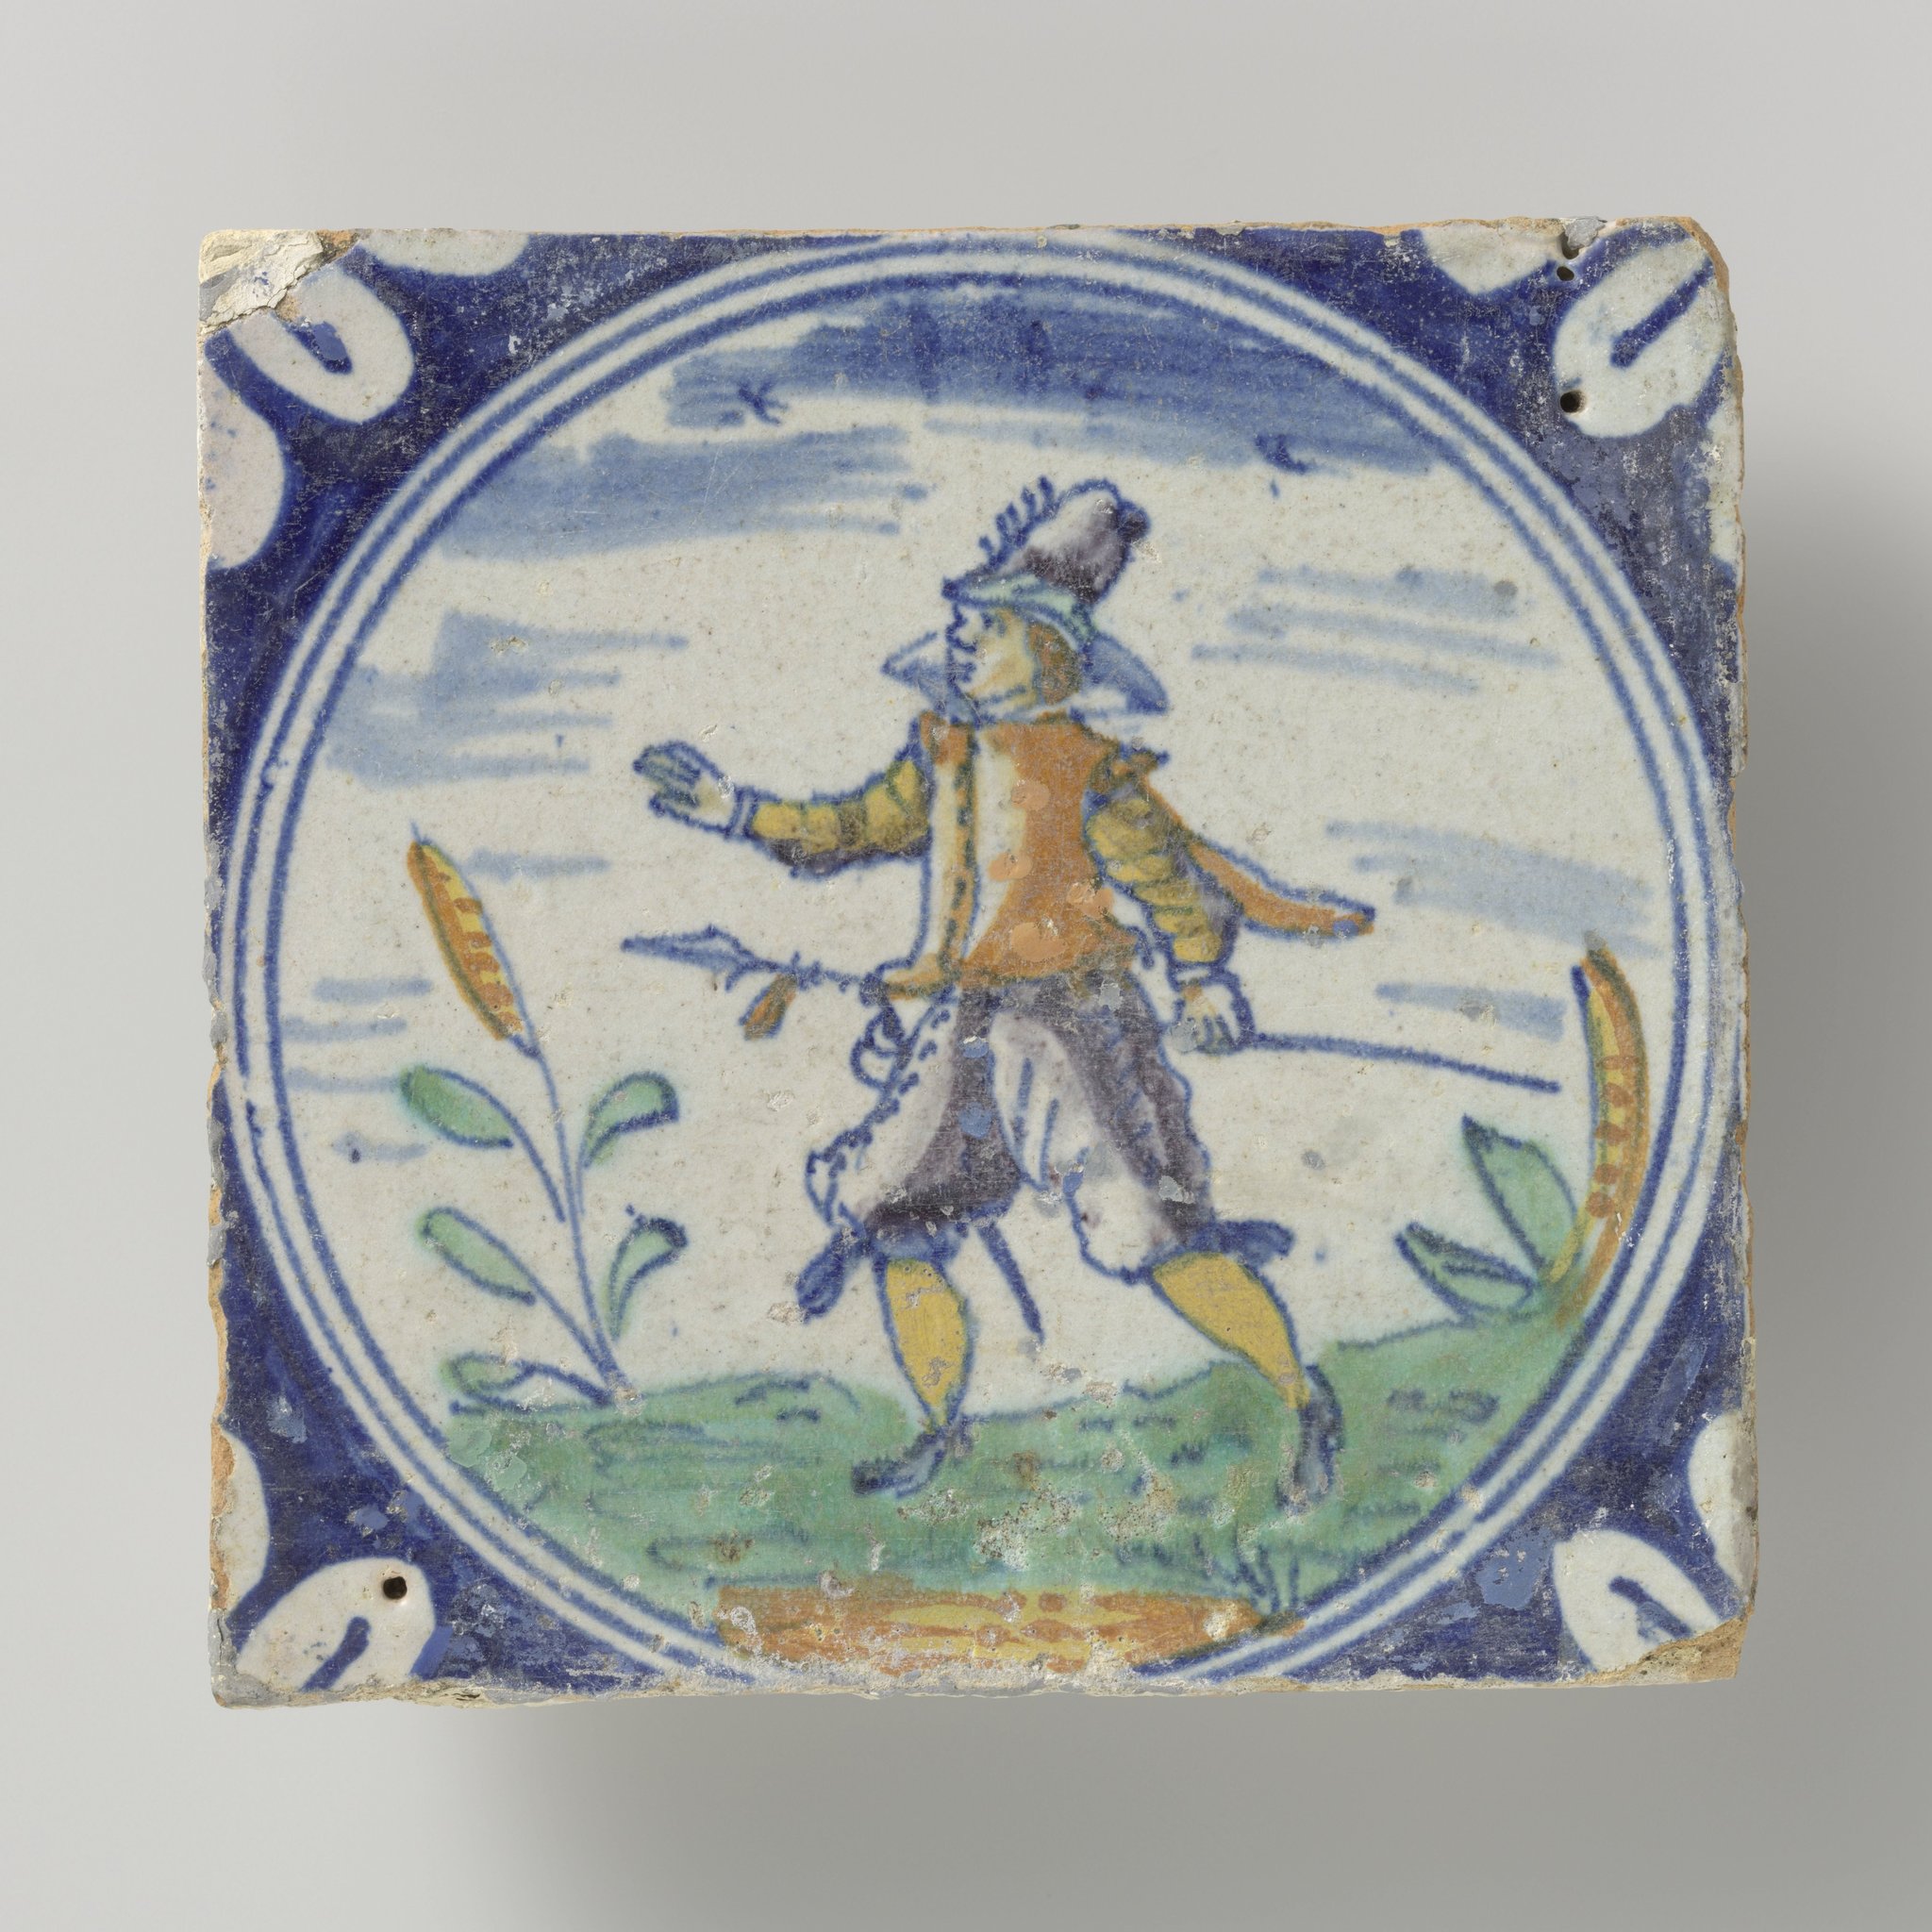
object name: tile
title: Tegel, veelkleurig beschilderd met een soldaat of een vaandeldrager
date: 1625-1700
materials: earthenware, glaze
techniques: maiolica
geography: netherlands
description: Tegel, veelkleurig beschilderd met een soldaat of een vaandeldrager.